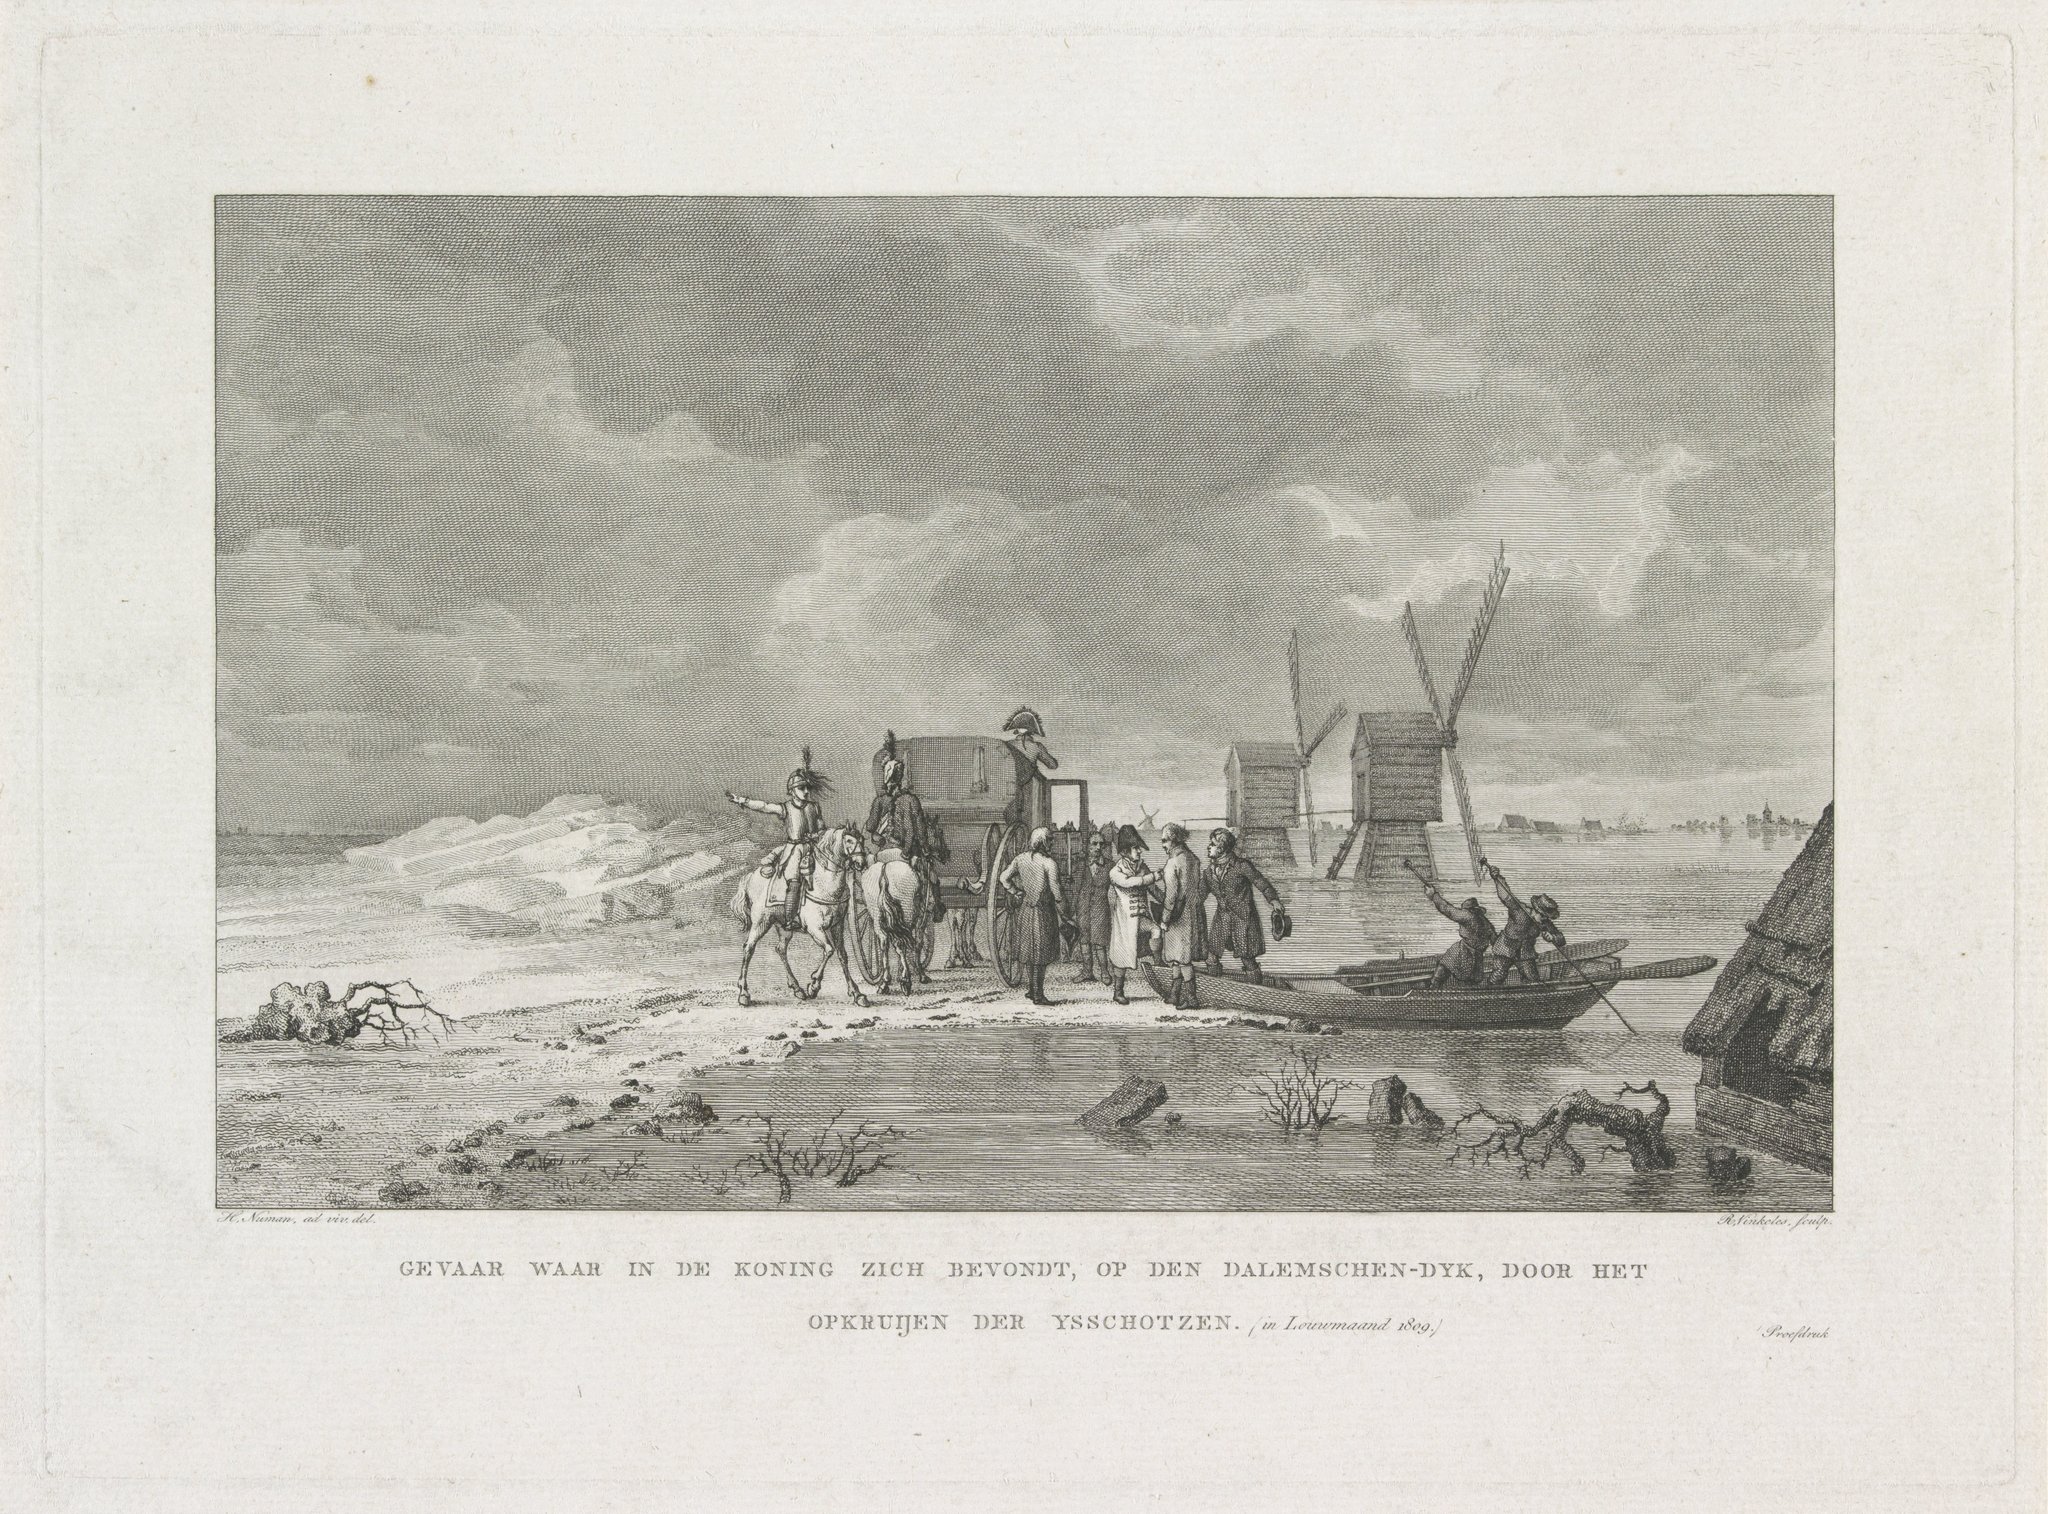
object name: print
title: Lodewijk Napoleon op de Dalemse dijk, 1809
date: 1809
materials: paper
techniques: engraving, etching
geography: netherlands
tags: louis napoleon (king of holland), dike-break, four-wheeled, animal-drawn vehicle, e.g.: cab, carriage, coach, windmill, drift ice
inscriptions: collector's mark: Lugt 2228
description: Koning Lodewijk Napoleon op de Dalemse dijk in de door dijkdoorbraken en overstromingen getroffen Betuwe, januari 1809. In het midden de koets met koetsier met twee paarden met ruiters erachter. Rechts van de koets vijf mannen. Rechts voor een roeiboot. Op de achtergrond twee molens.